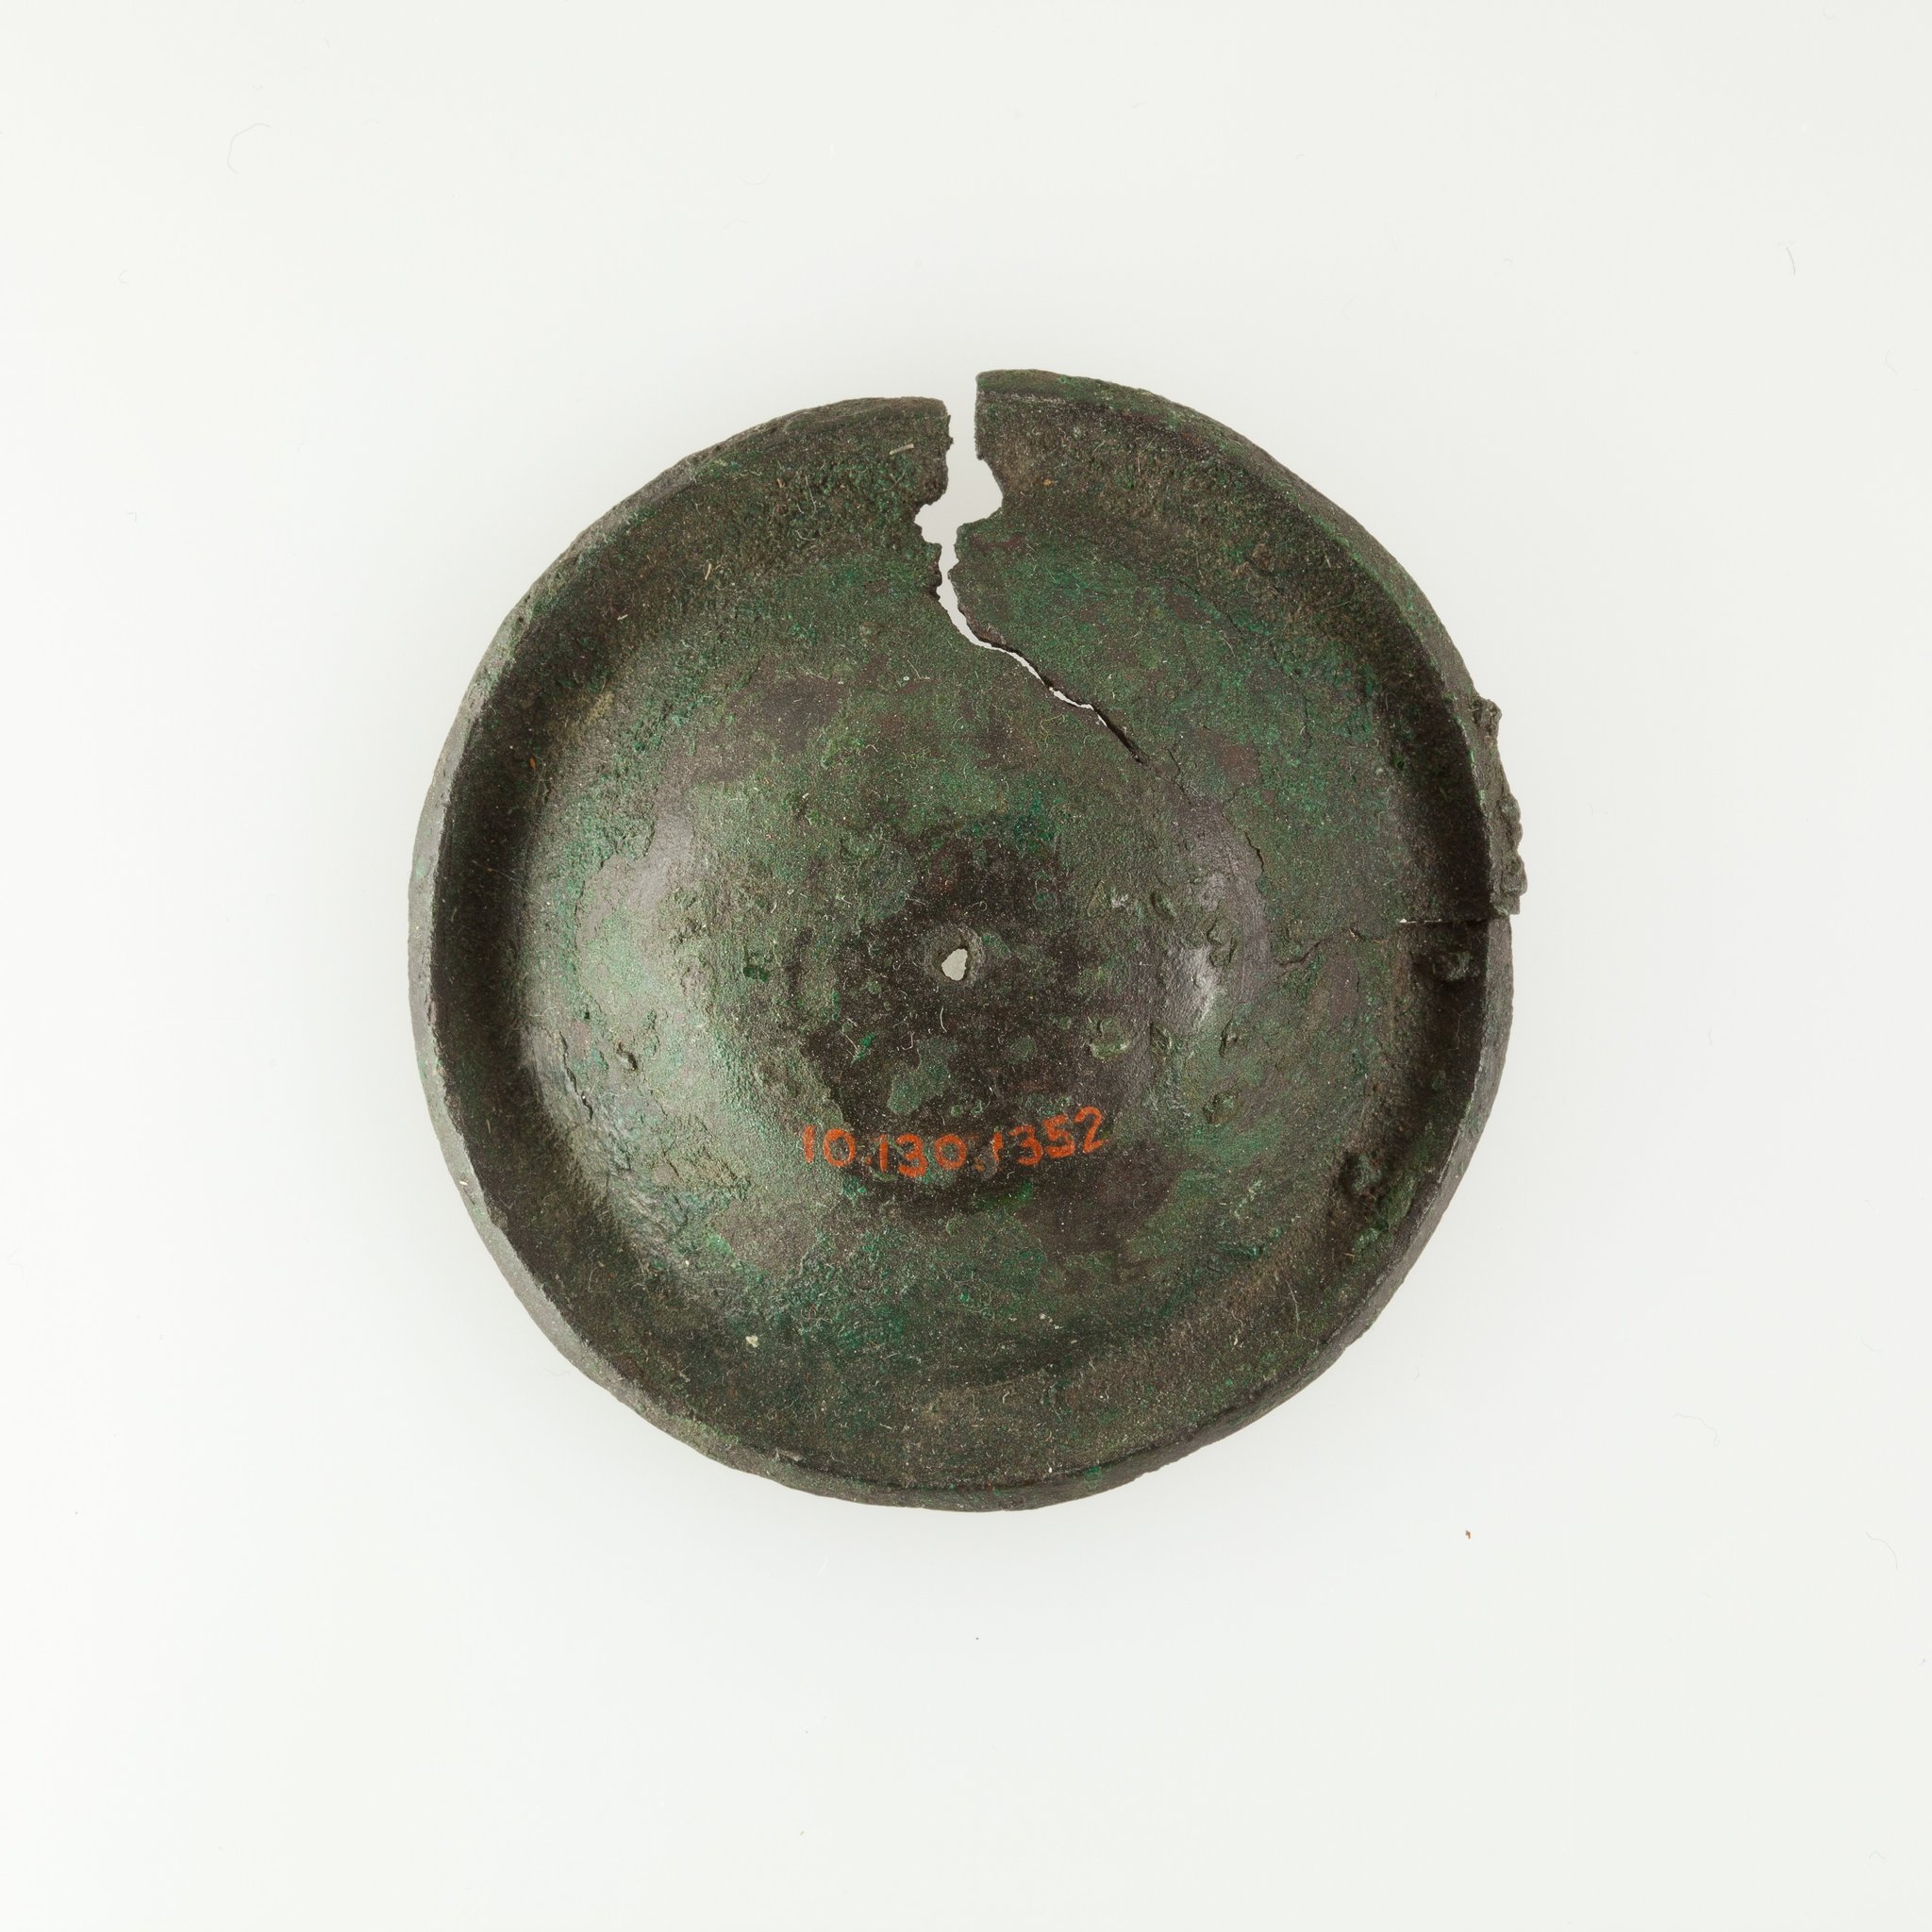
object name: music, cymbal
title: Cymbal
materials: copper alloy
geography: egypt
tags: musical instruments